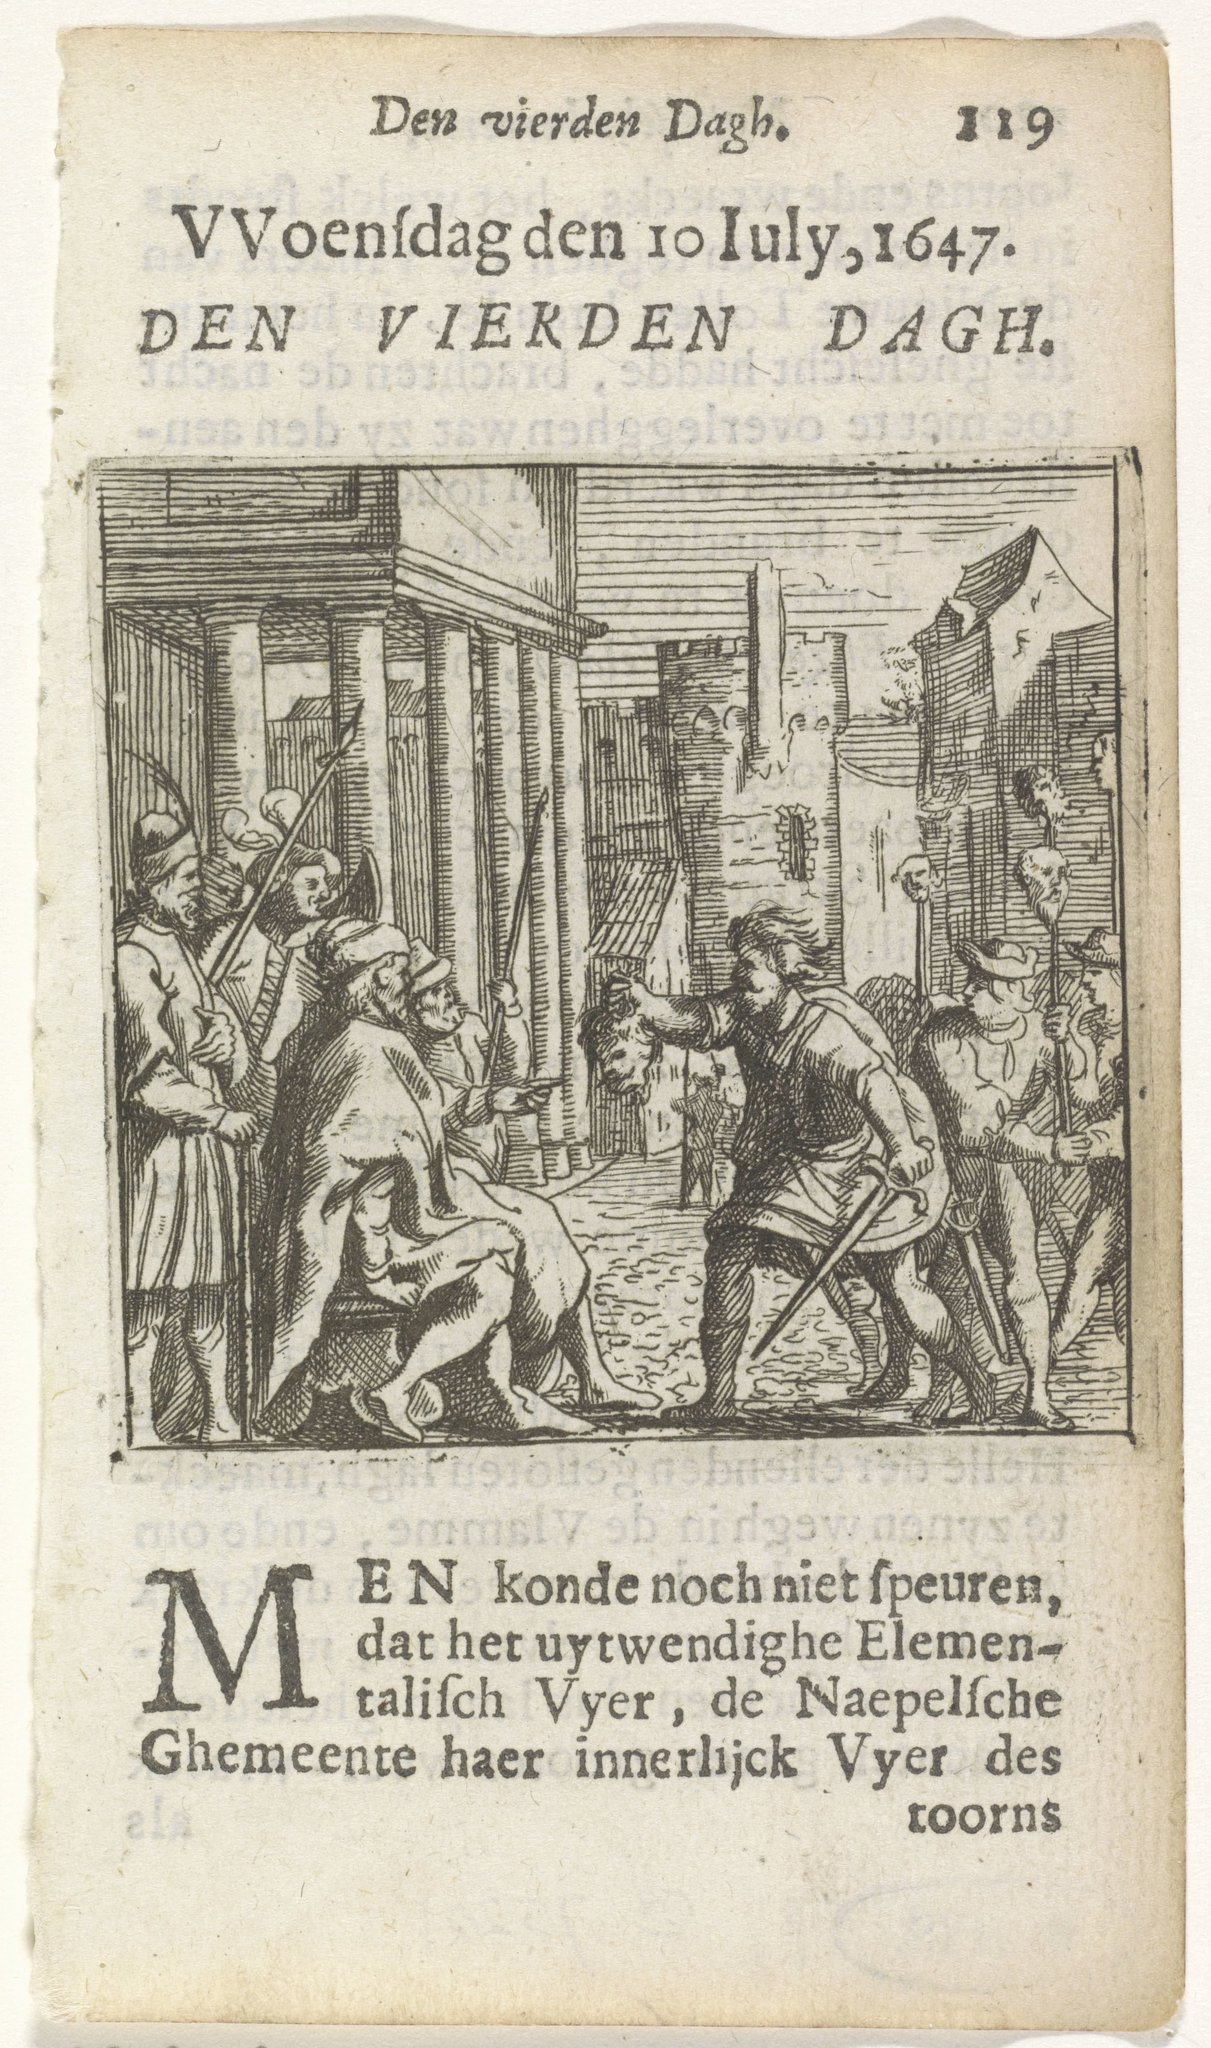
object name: book illustration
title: Gebeurtenis op 10 juli 1647 tijdens de Napolitaanse opstand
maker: Anonymous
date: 1652-1664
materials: paper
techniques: engraving, etching, letterpress printing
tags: head of a beheaded person, revolution, revolt, naples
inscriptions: collector's mark: Lugt 2228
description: Prent uit een van de uitgaven van: Giraffi, Alessandro. Het eerste deel der Napelsche beroerte. [Vertaald uit het Italiaans door] Lambert van den Bos. 1652-1664.